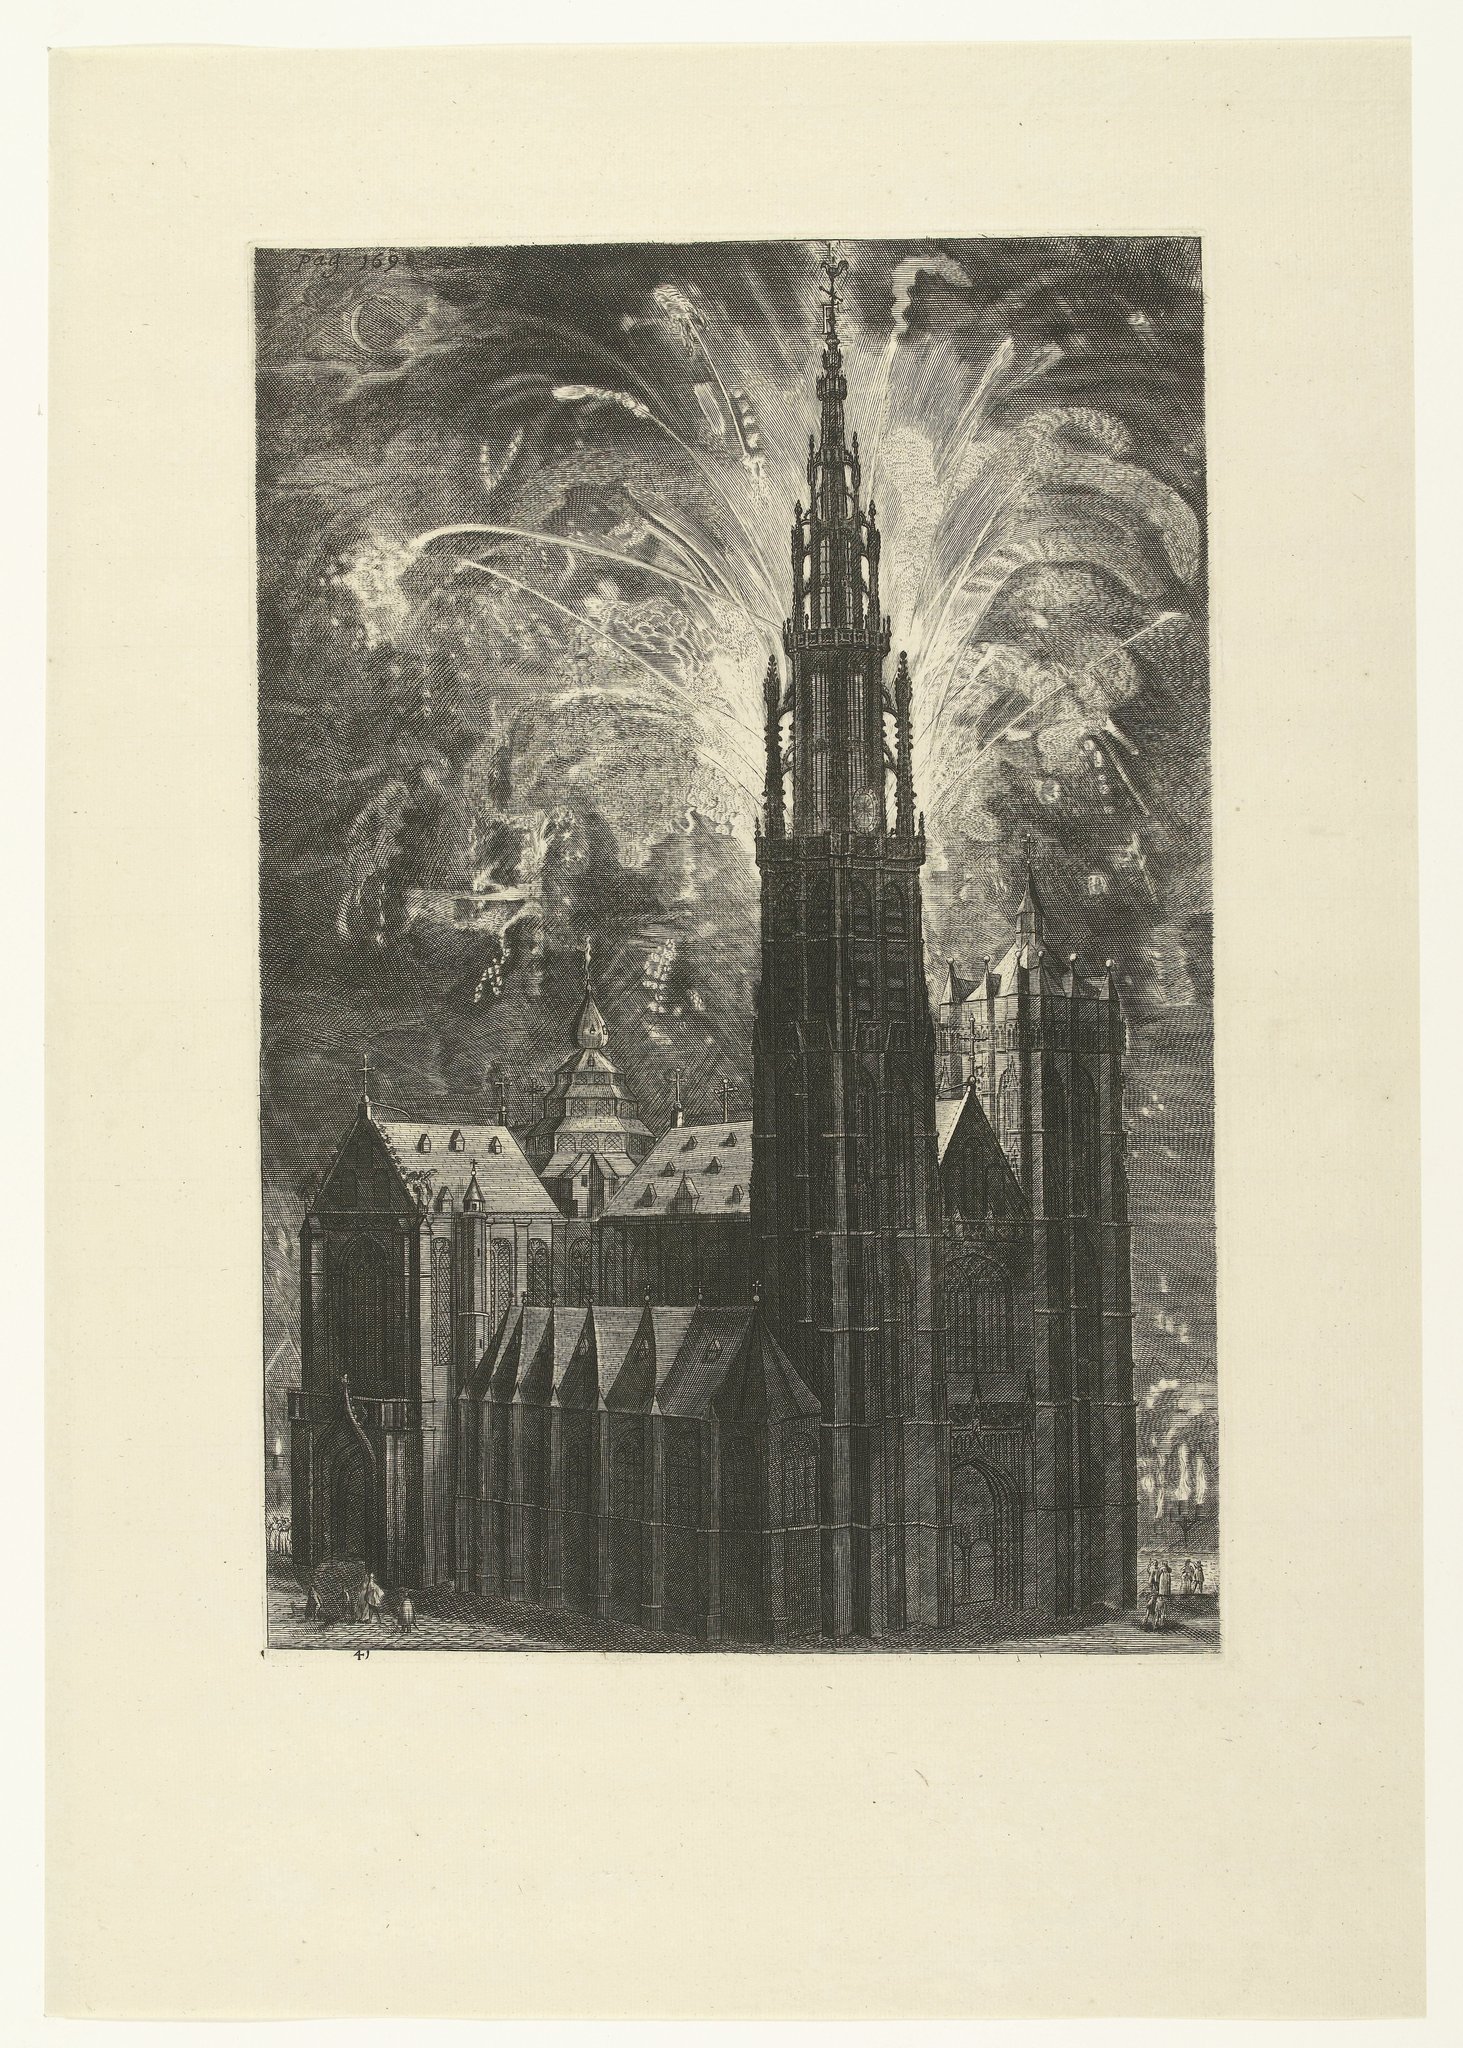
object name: print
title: Turris Templi Mariani, è quâ exhibita Festorum ignium hilaria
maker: Anonymous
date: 1639-1641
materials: paper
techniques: engraving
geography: southern netherlands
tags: landvoogd der zuidelijke nederlanden ferdinand van oostenrijk, triumphal entry and public reception, pageant, 'entrée solennelle', 'joyeuse entrée', bonfire, fire-works, festivities (+ illumination, fire-works ~ festive activities), antwerp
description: Oorspronkelijk gebruikt als illustratie in: C. Gevartius, Pompa introitus ... Ferdinandi Austriaci Hispaniarum Infantis ... a S.P.Q. Antverp, decreta et adornata, cum ... ad Norlingam parta victoria Antverpiam ... adventu suo bearet ... 1635 : arcus, pegmata iconesque a Pet. Paulo Rubenio ... inventas & delineatas inscriptionibus & elogiis ornabat, libroque commentario illustrabat, Theodoor van Thulden en Joannes Meursius, Antwerpen 1641, pl. 41.